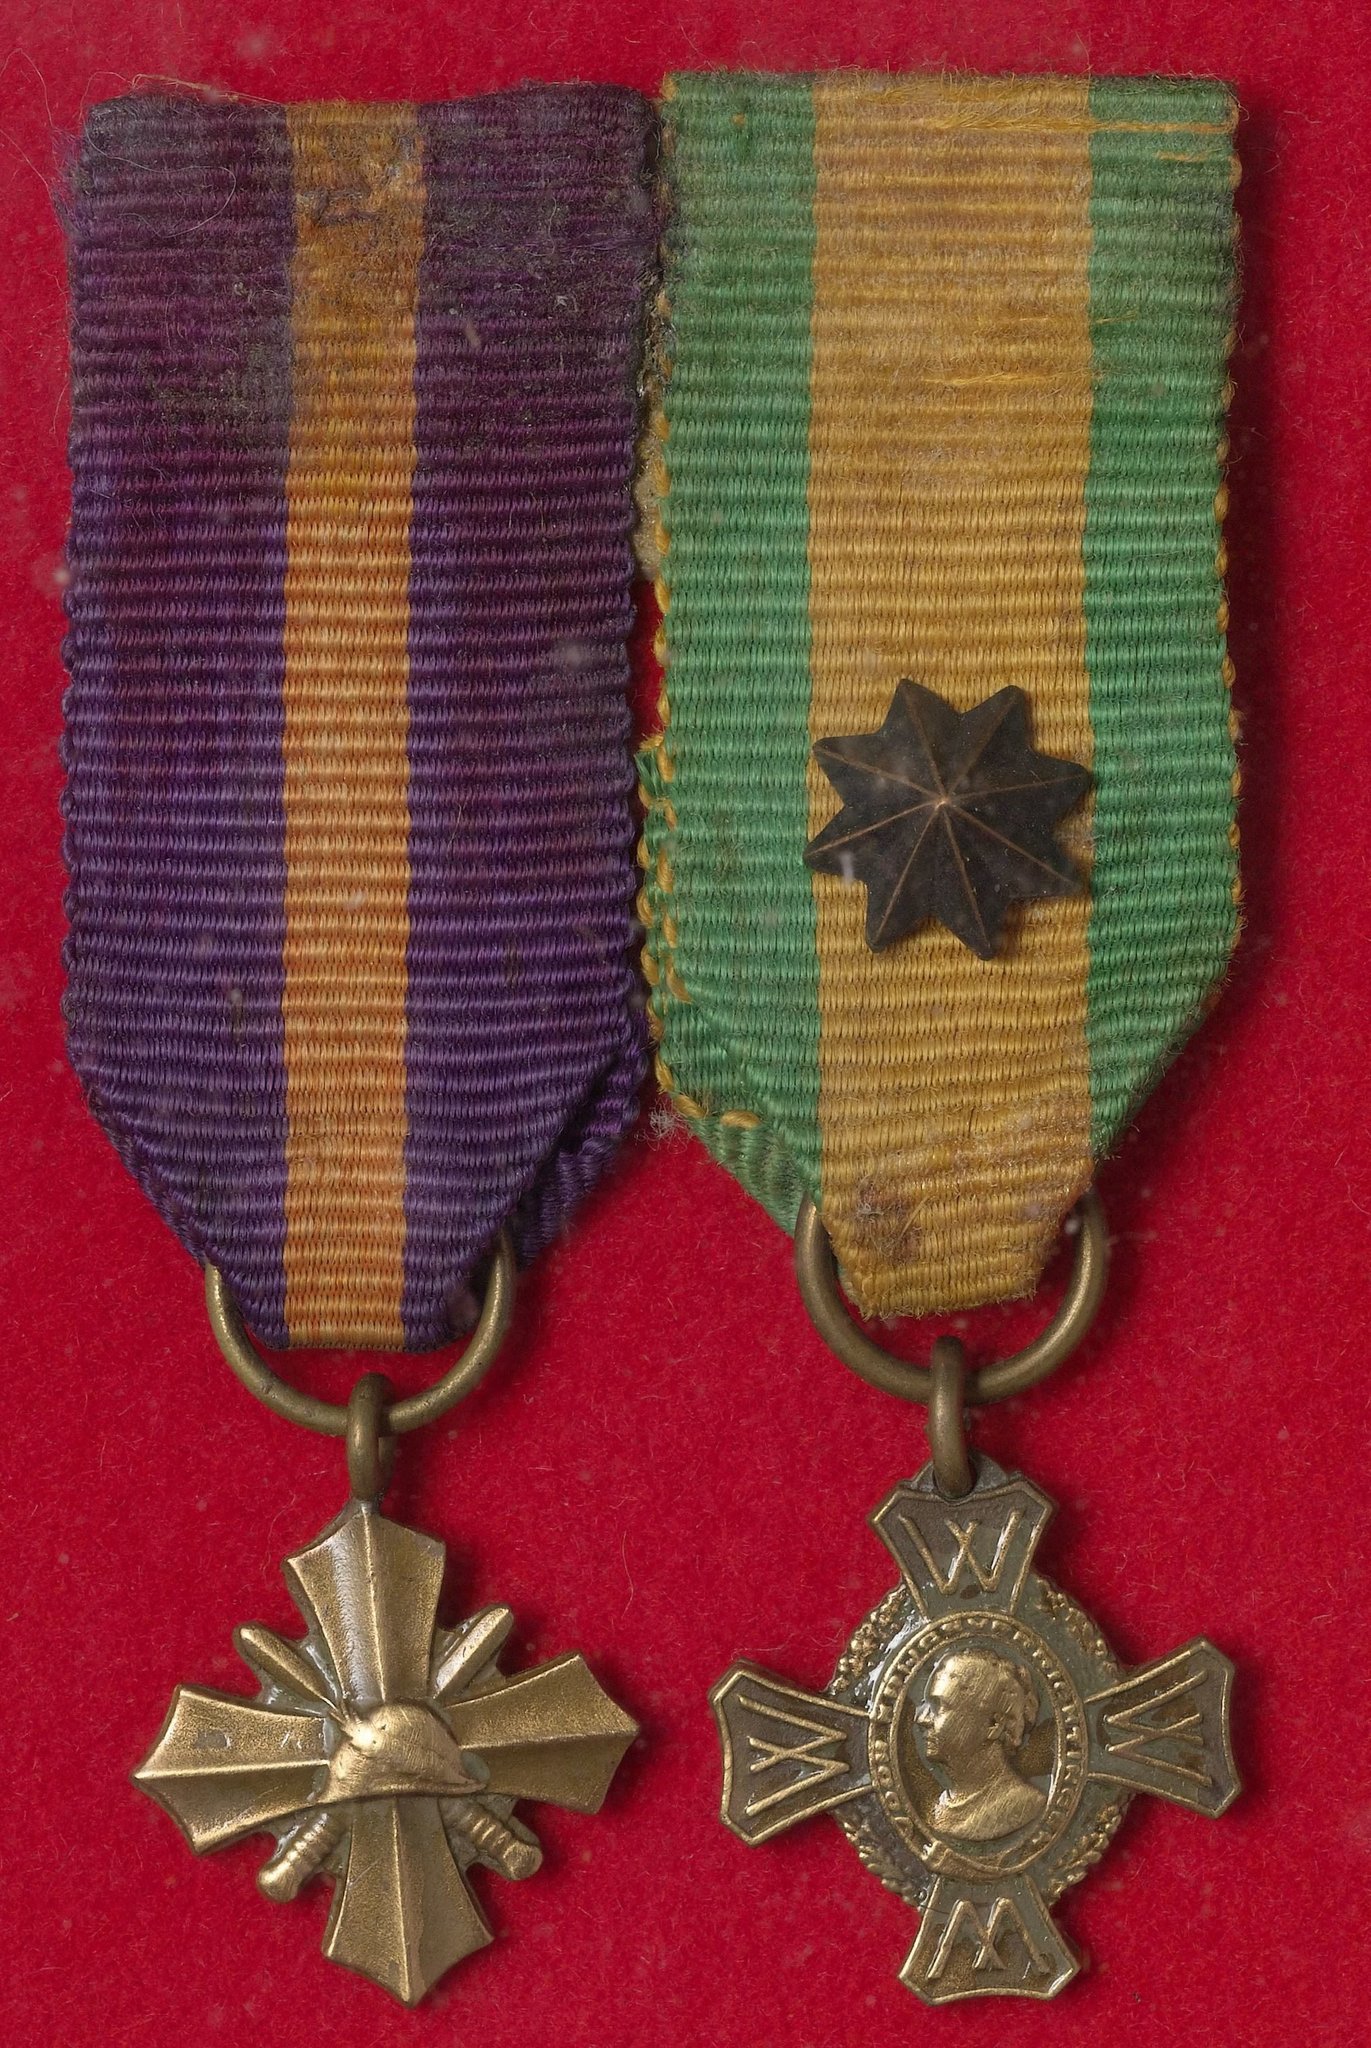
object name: medal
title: Nederlands mobilisatiekruis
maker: Anonymous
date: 1938-1940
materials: metal, textile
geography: netherlands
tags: amsterdam, tonny van renterghem, netherlands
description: Nederlands mobilisatiekruis. Koperkleurig kruis met helm. Lint paars en oranje.